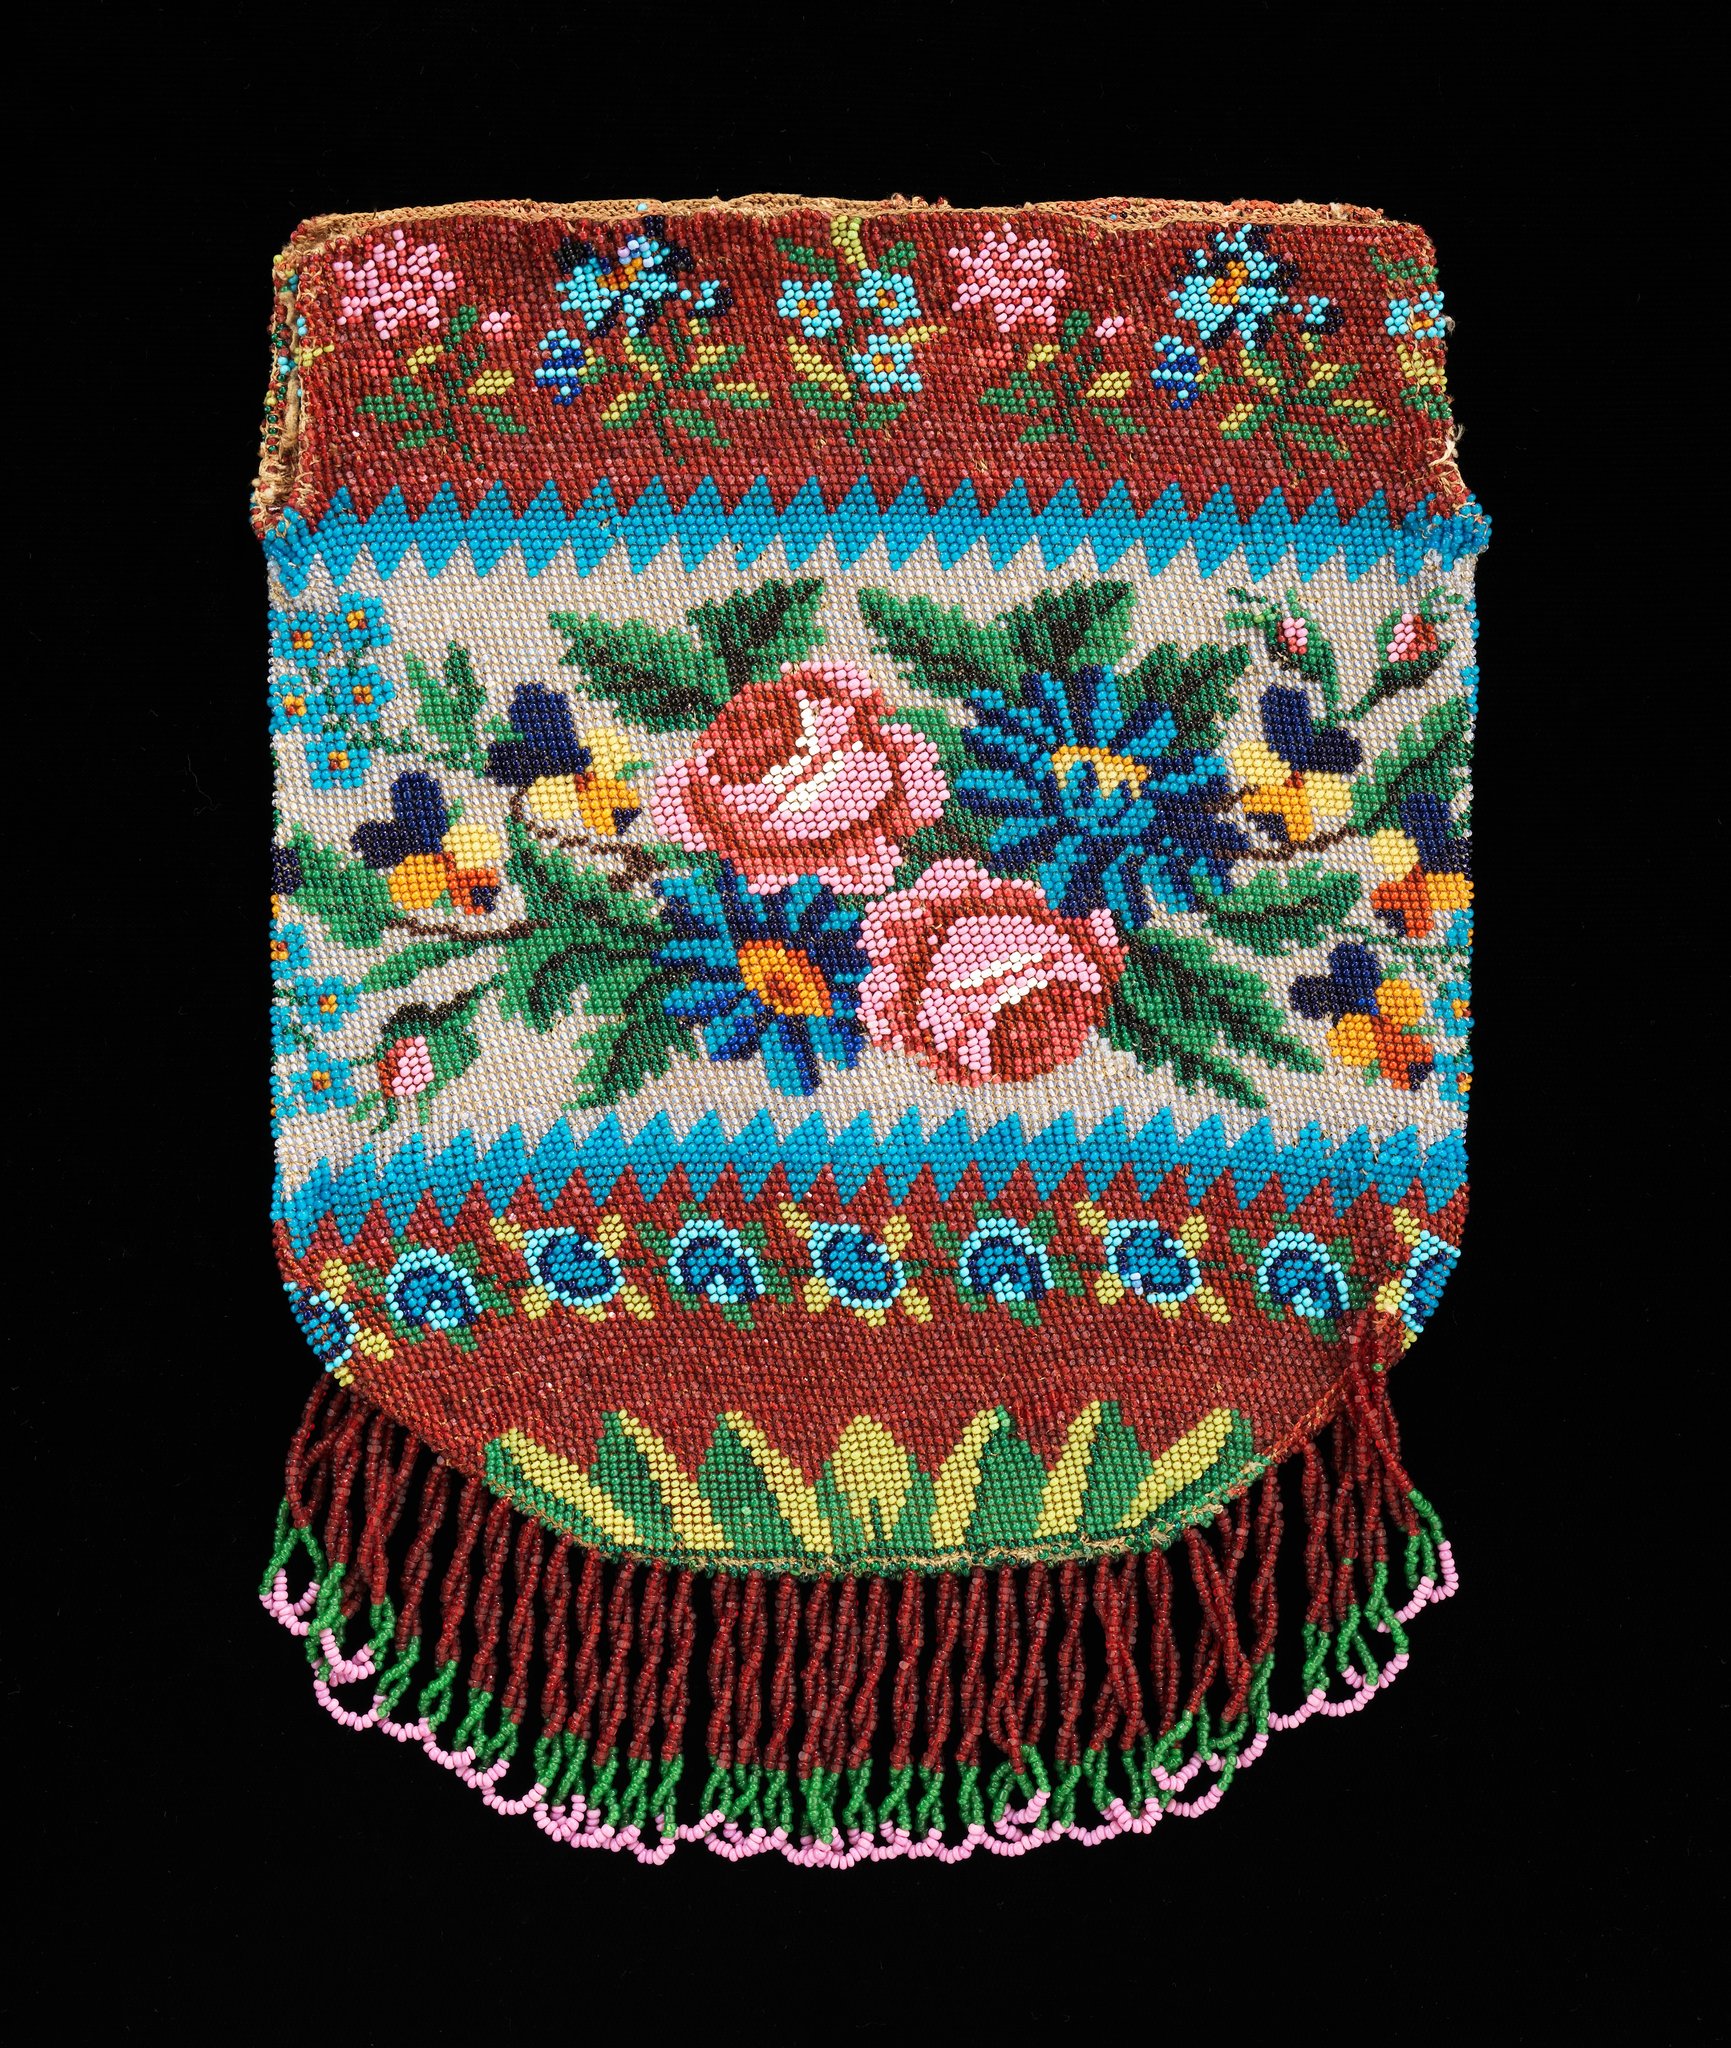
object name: bag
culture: american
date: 1830-1860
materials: glass, linen